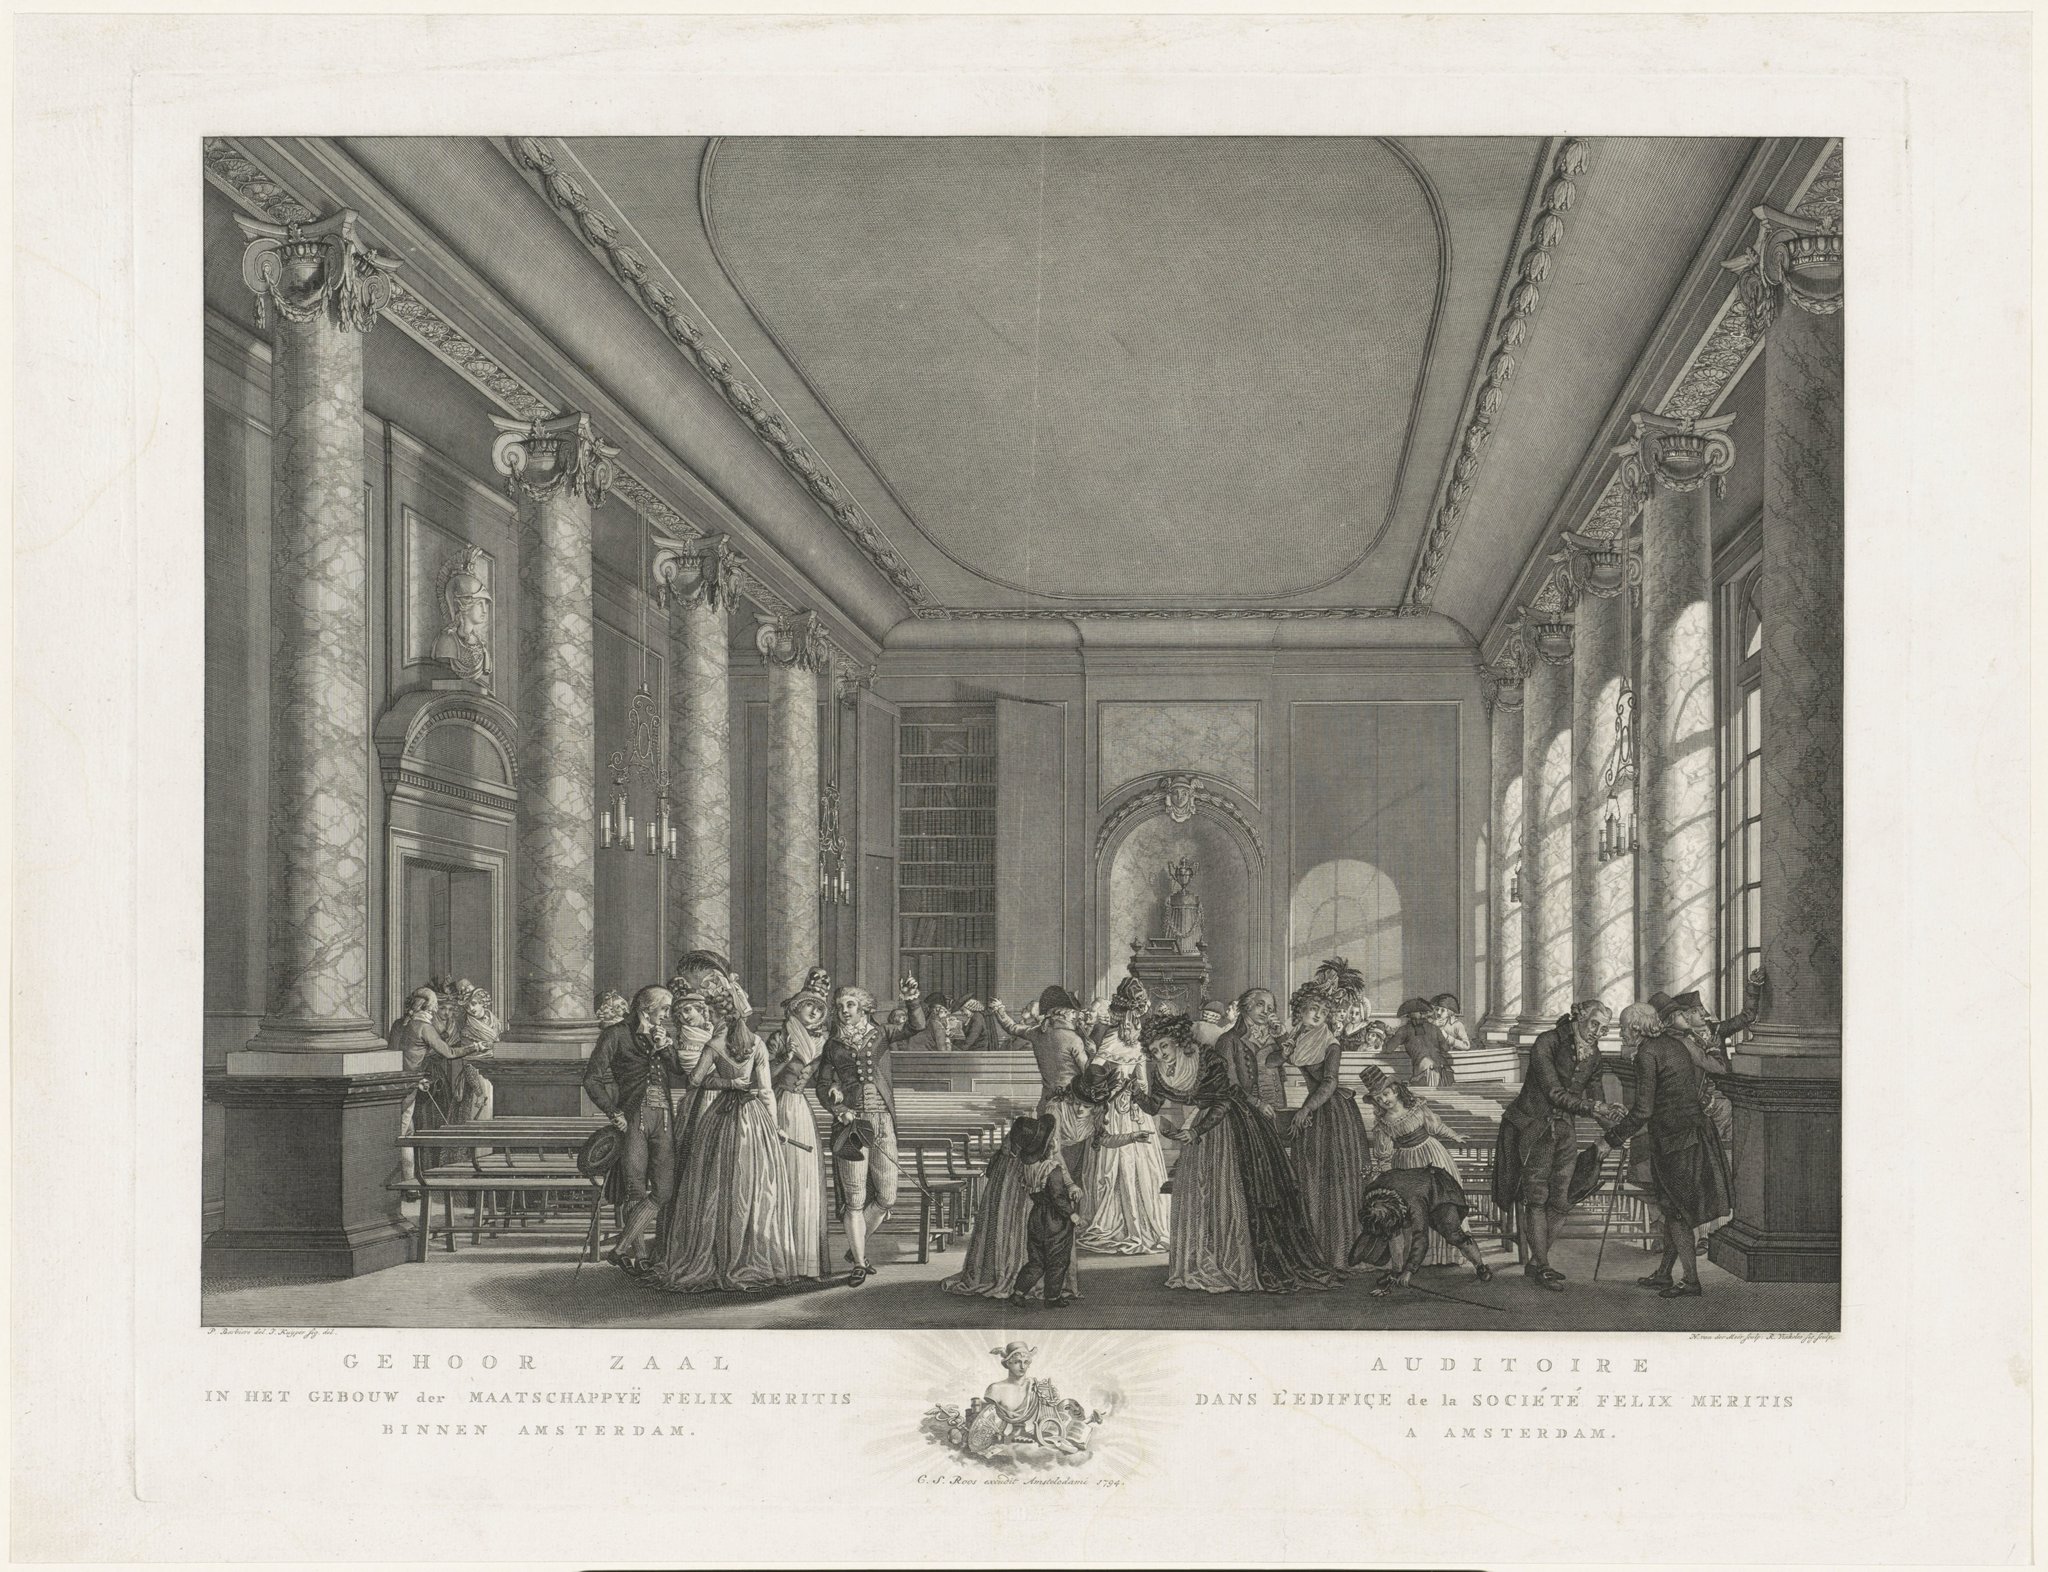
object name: print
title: Gehoor Zaal in het Gebouw der Maatschappyë Felix Meritis binnen Amsterdam / Auditoire dans l'Edifiçe de la Société Felix Meritis a Amsterdam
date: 1794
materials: paper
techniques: engraving, etching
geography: northern netherlands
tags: learned society, academy of sciences, amsterdam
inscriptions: collector's mark:, collector's mark: Lugt 2228, inscription: ‘C: S: Roos’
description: Bezoekers in de Gehoorzaal in het gebouw van de maatschappij Felix Meritis te Amsterdam, ingewijd in 1789.